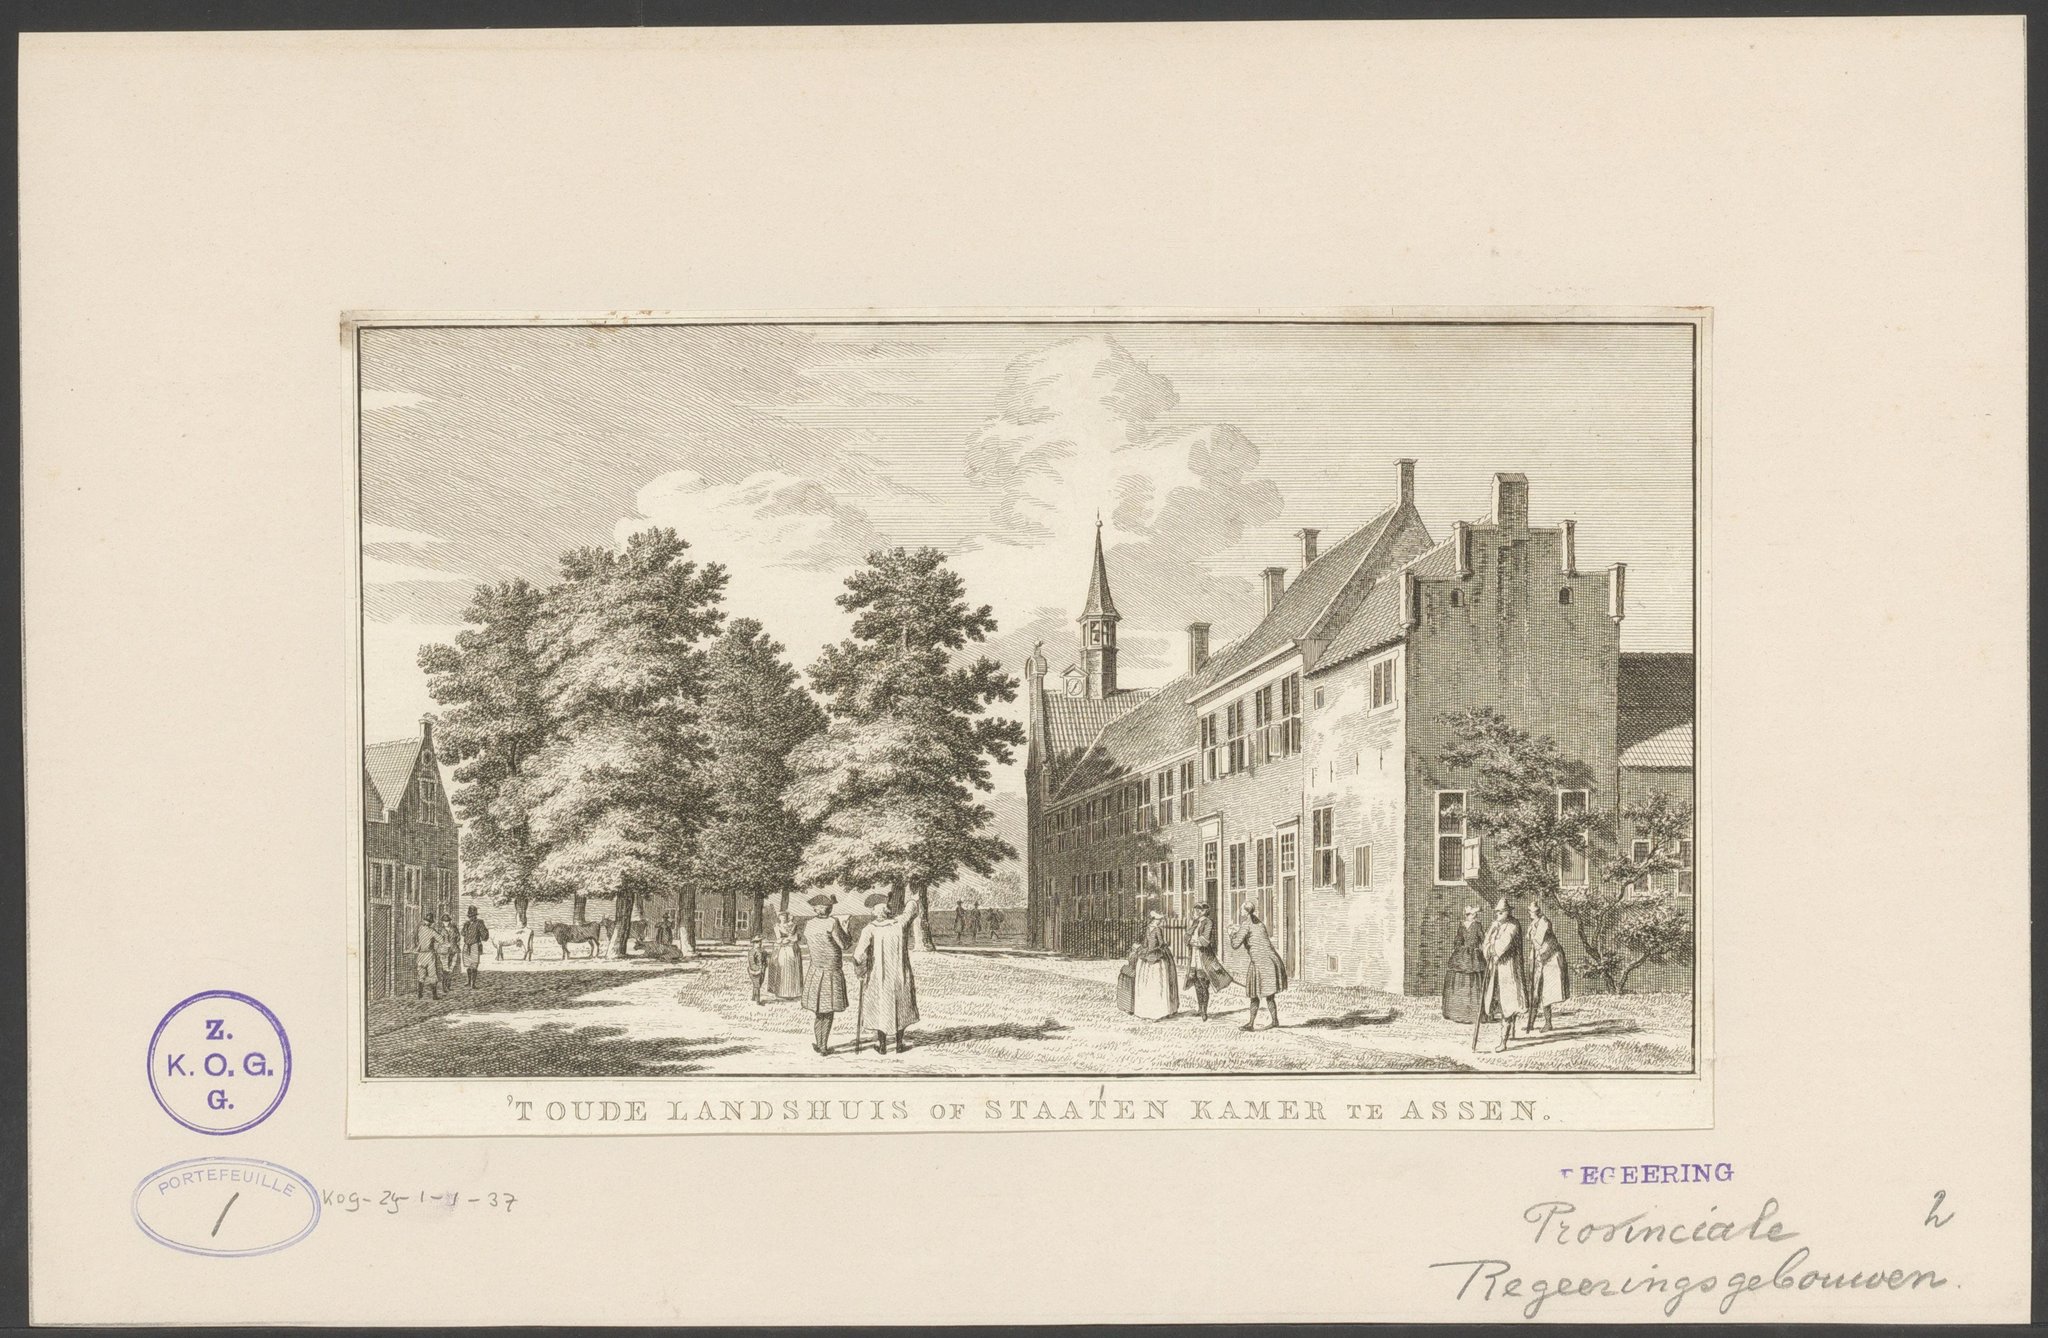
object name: print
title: 't Oude Landshuis of Staaten Kamer te Assen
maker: jan caspar philips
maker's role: draughtsman, print maker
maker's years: 1700-1775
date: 1720-1760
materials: paper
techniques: etching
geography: netherlands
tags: representation of real building (either existing or having existed)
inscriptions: collector's mark: Lugt 1641, collector's mark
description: Gebruikt als illustratie in: Hedendaagsche Historie of Tegenwoordige Staat van alle Volkeren; XXXIIIste Deel Behelzende de Beschryving der Vereenigde Nederlanden ... Drenthe, 1795, tussen blz. 104-105.